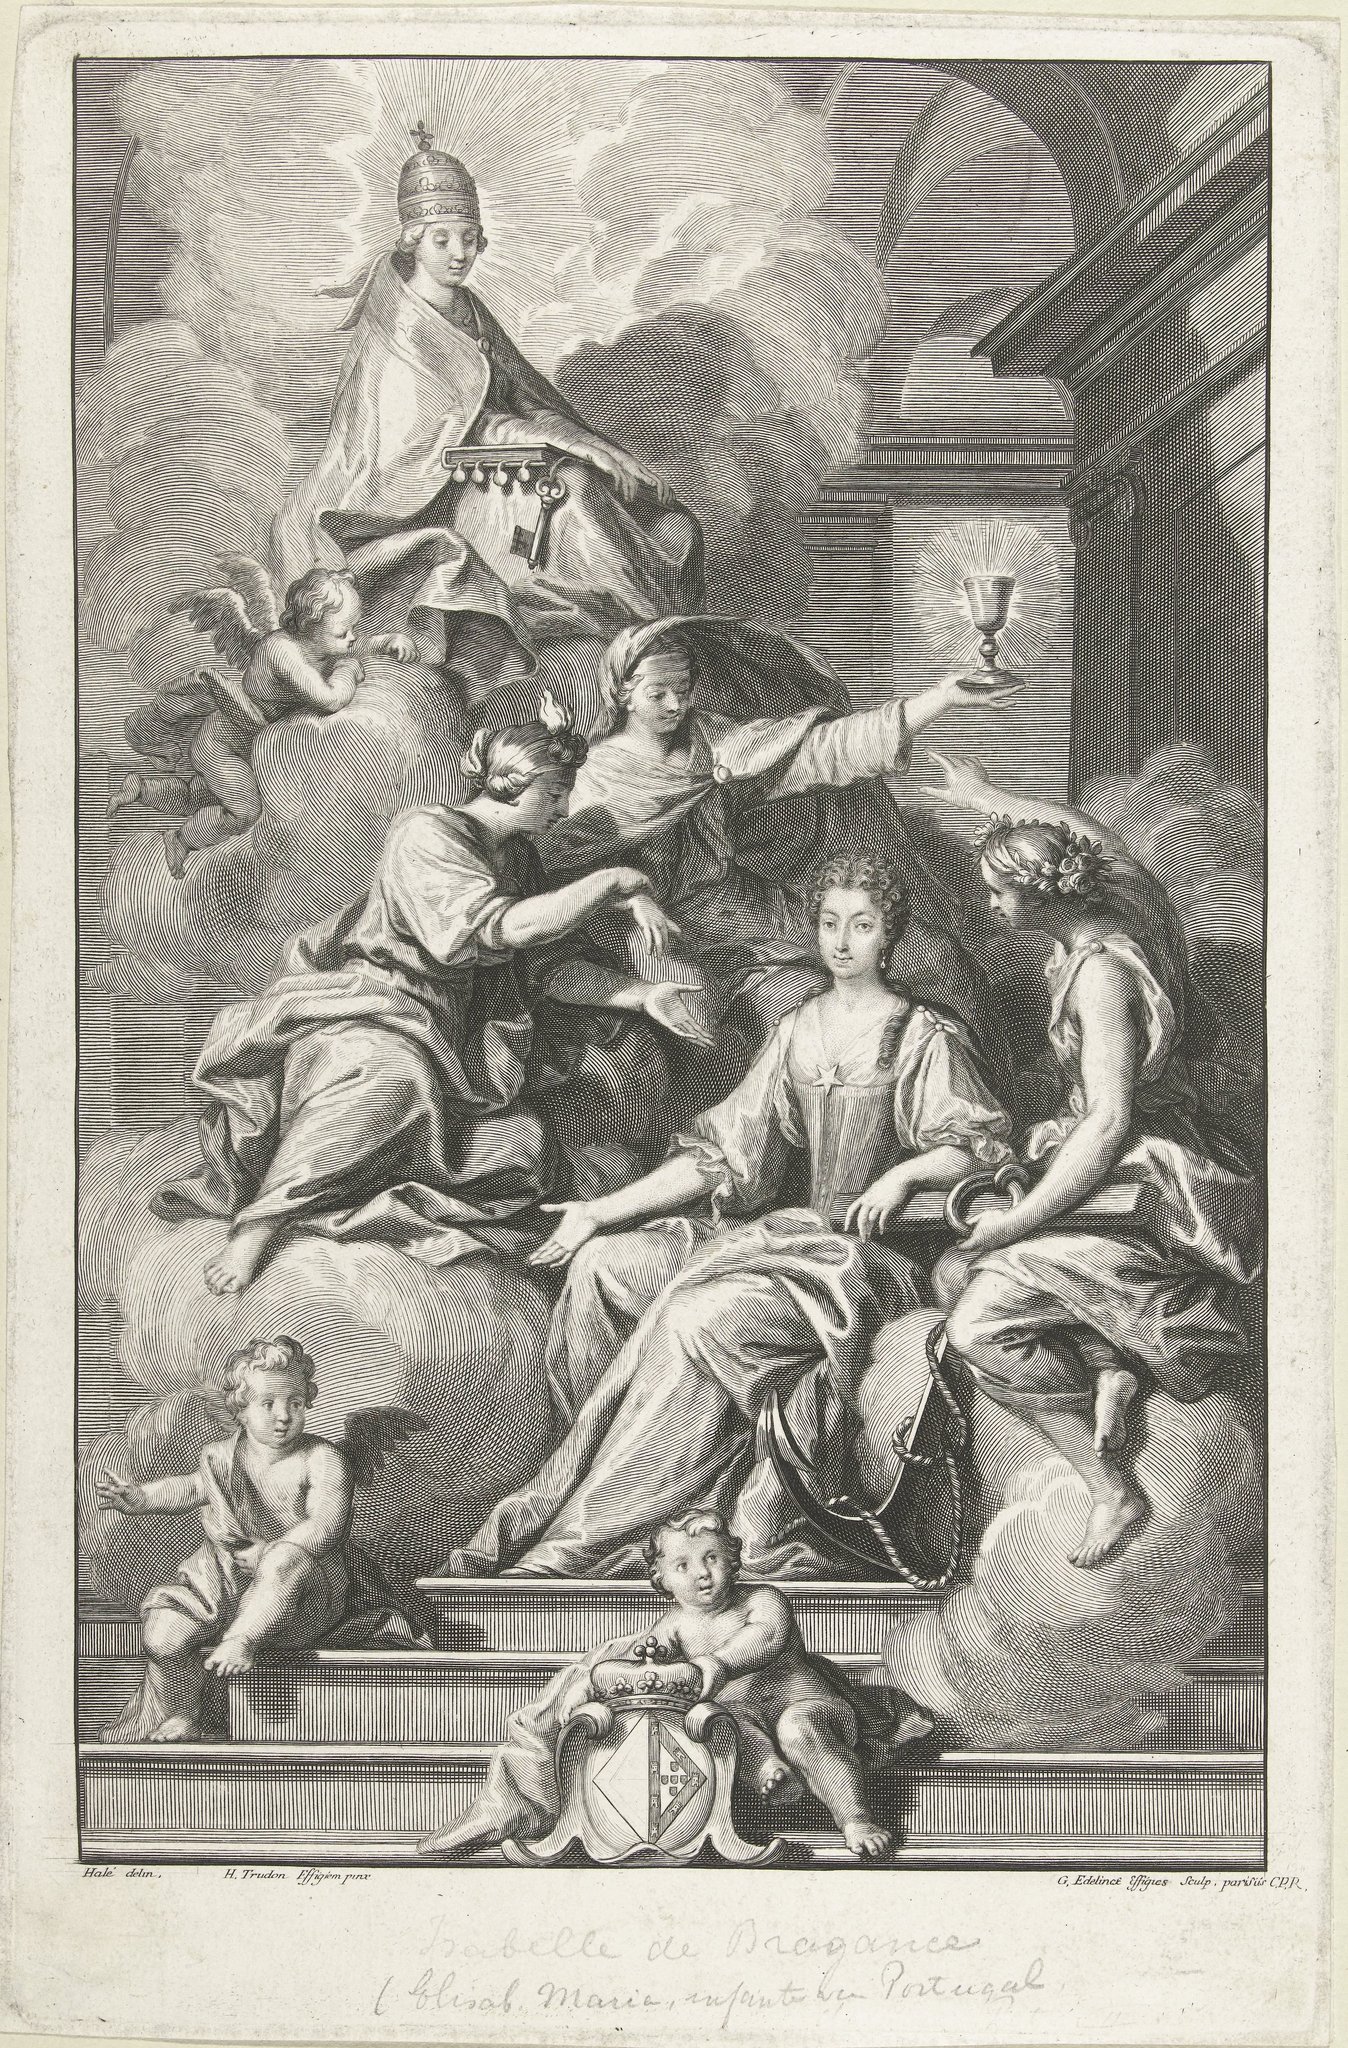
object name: print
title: Isabelle de Bragance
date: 1675-1707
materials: paper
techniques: engraving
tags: the three theological virtues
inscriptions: collector's mark: Lugt 240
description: Isabelle de Bragance (1669-1690), prinses van Portugal, zittend afgebeeld tussen drie vrouwlijke personificaties van geloof, hoop en liefde. Van boven kijkt de personificatie van religie toe en op de treden op de voorgrond zitten twee engeltjes, waarvan één het wapen van de prinses vasthoudt.